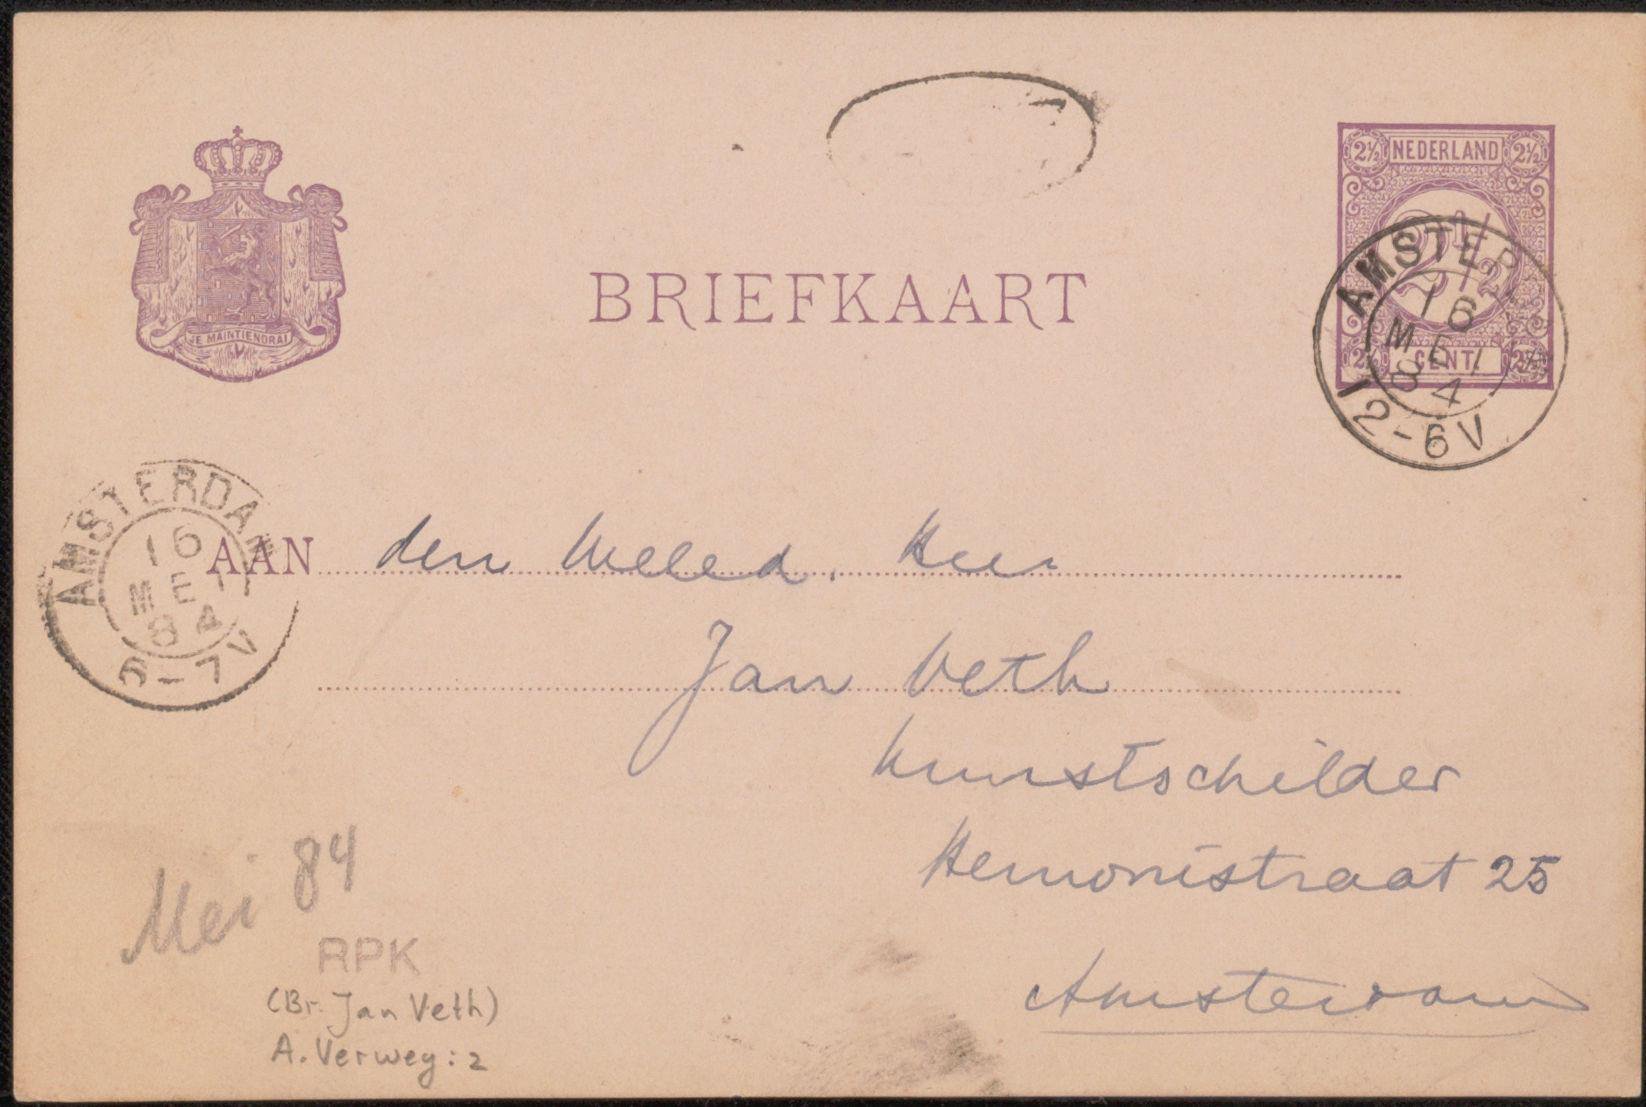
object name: postcard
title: Briefkaart aan Jan Veth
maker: albert verwey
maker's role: criticus, dichter, essayist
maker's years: 1865-1937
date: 1884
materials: cardboard, ink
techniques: pen, writing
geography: amsterdam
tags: dordrecht, painter, print maker, draughtsman, designer, jan veth, the hague, willem kloos, money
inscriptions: collector's mark: ‘RPK’